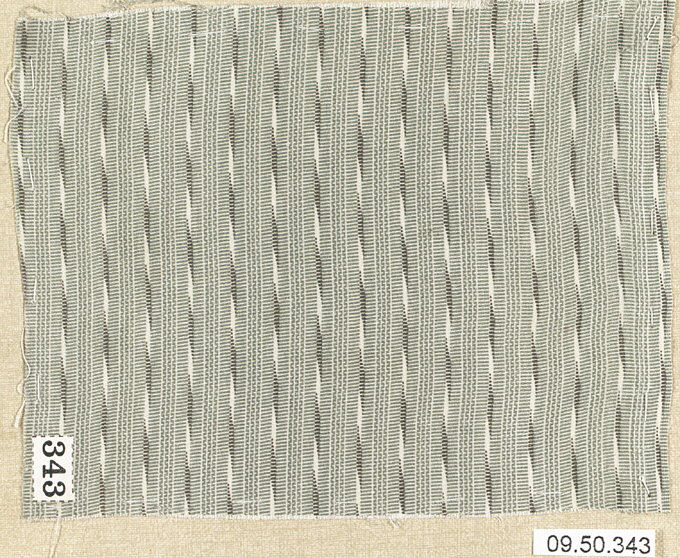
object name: piece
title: Piece (one of 116)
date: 1801-1900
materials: cotton